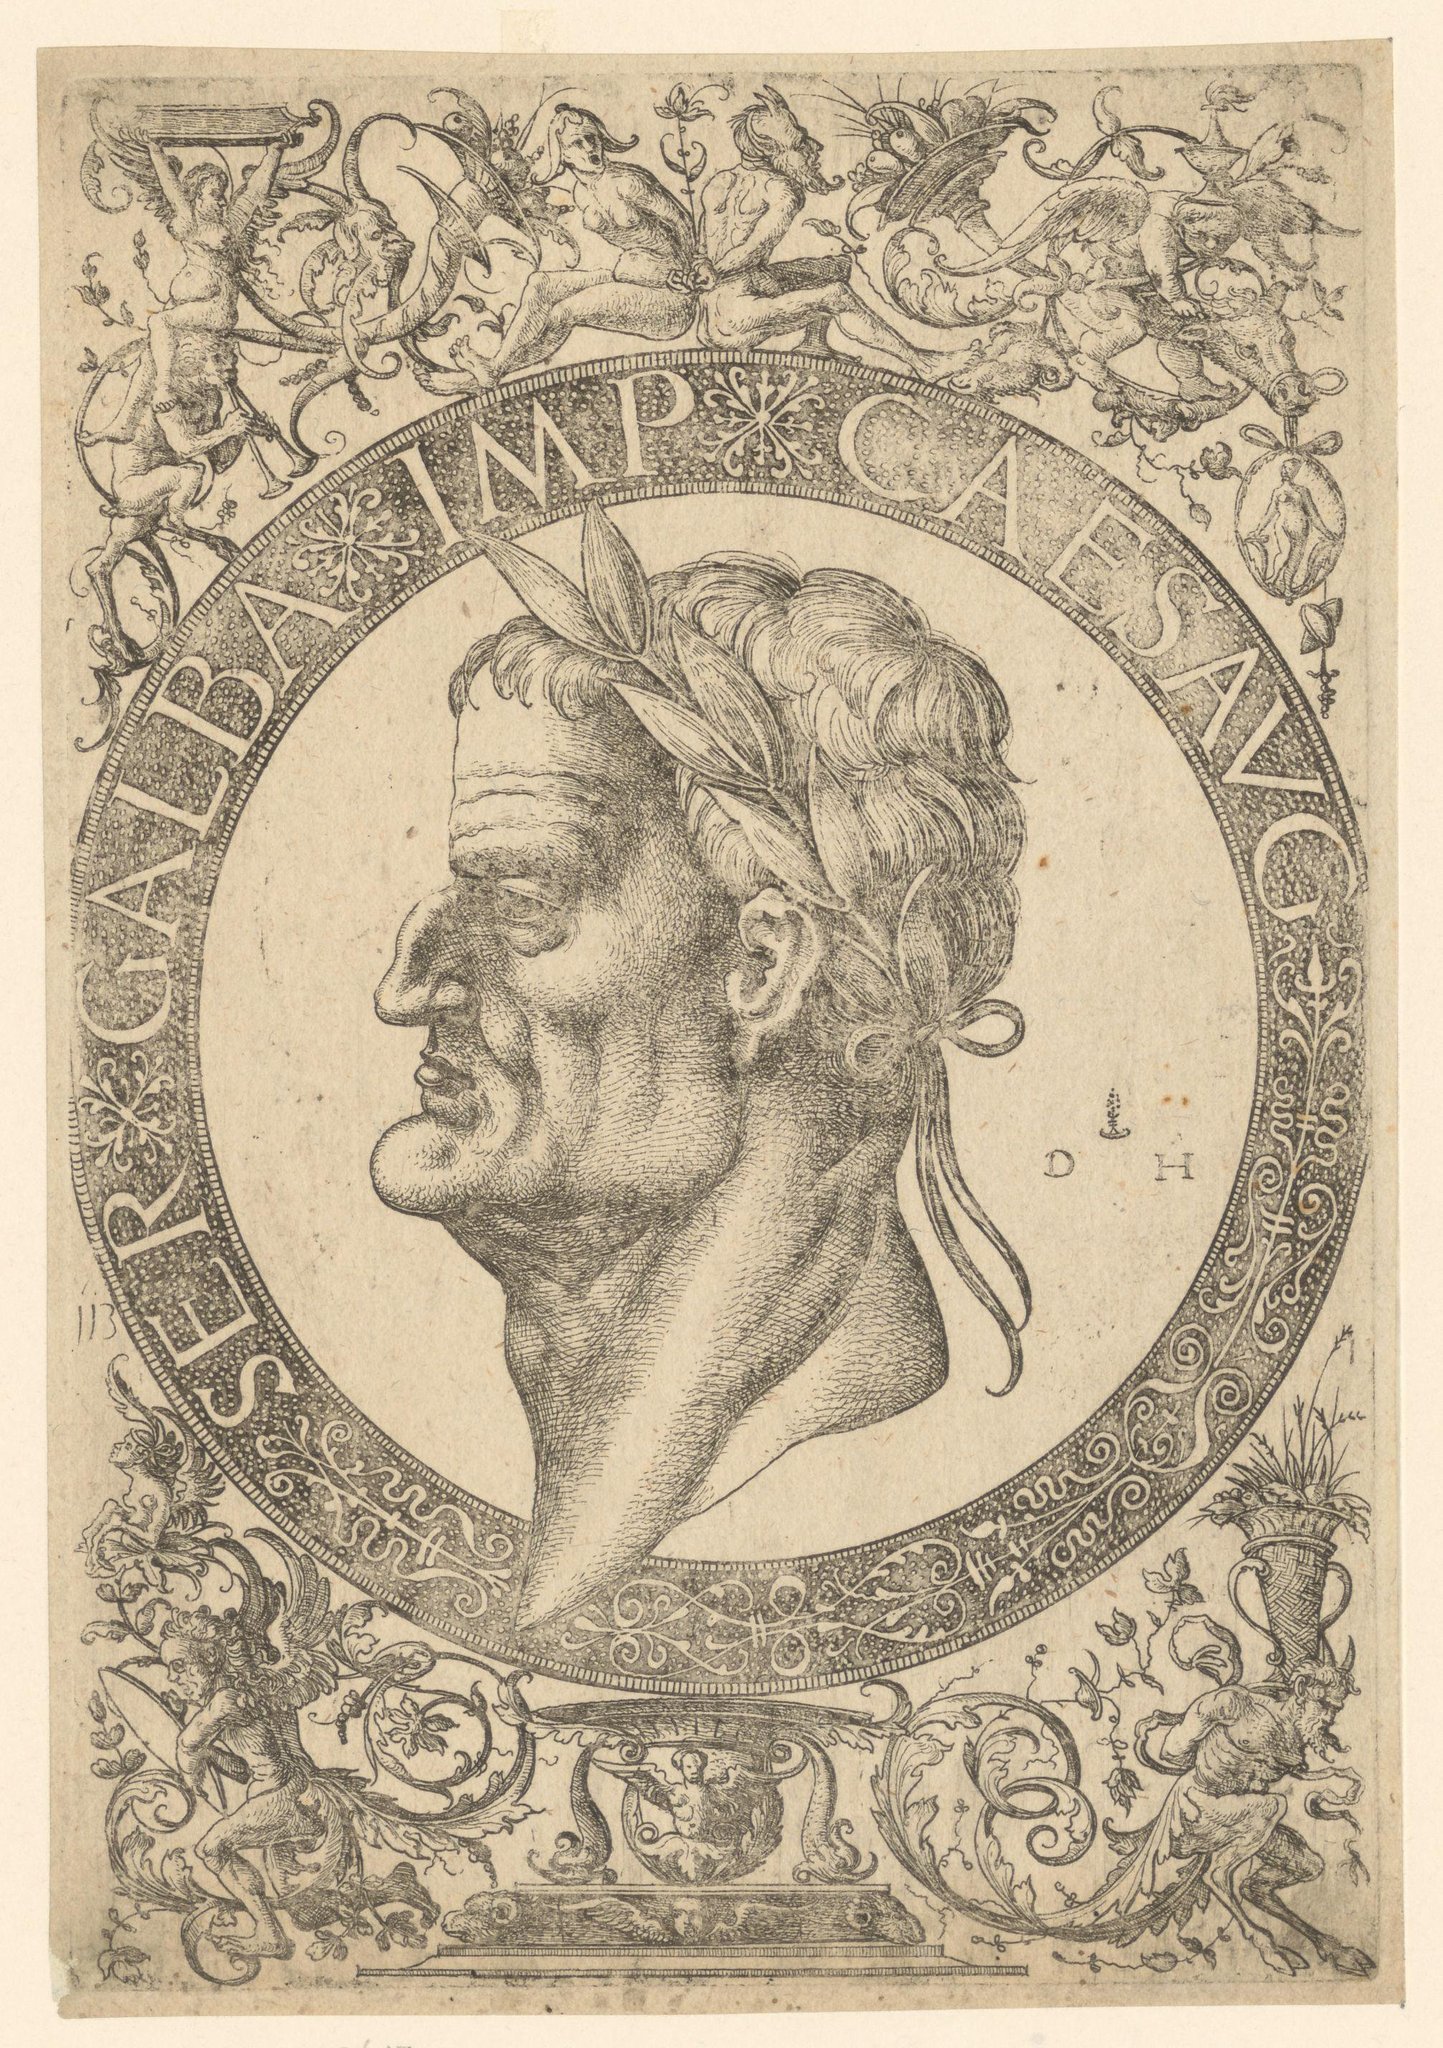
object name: print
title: Portret van Galba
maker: daniel hopfer (i)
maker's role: print maker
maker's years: 1470-1536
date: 1504-1536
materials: paper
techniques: etching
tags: ornament ~ grotesque, ornament ~ medallion, historical persons, pope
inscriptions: collector's mark: Lugt 2228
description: Borstbeeld van de Romeinse keizer Galba en profil naar links in een medaillon. Tekst in het Latijn in de omlijsting. Mythologische en groteske figuren sieren het kader om het medaillon heen.